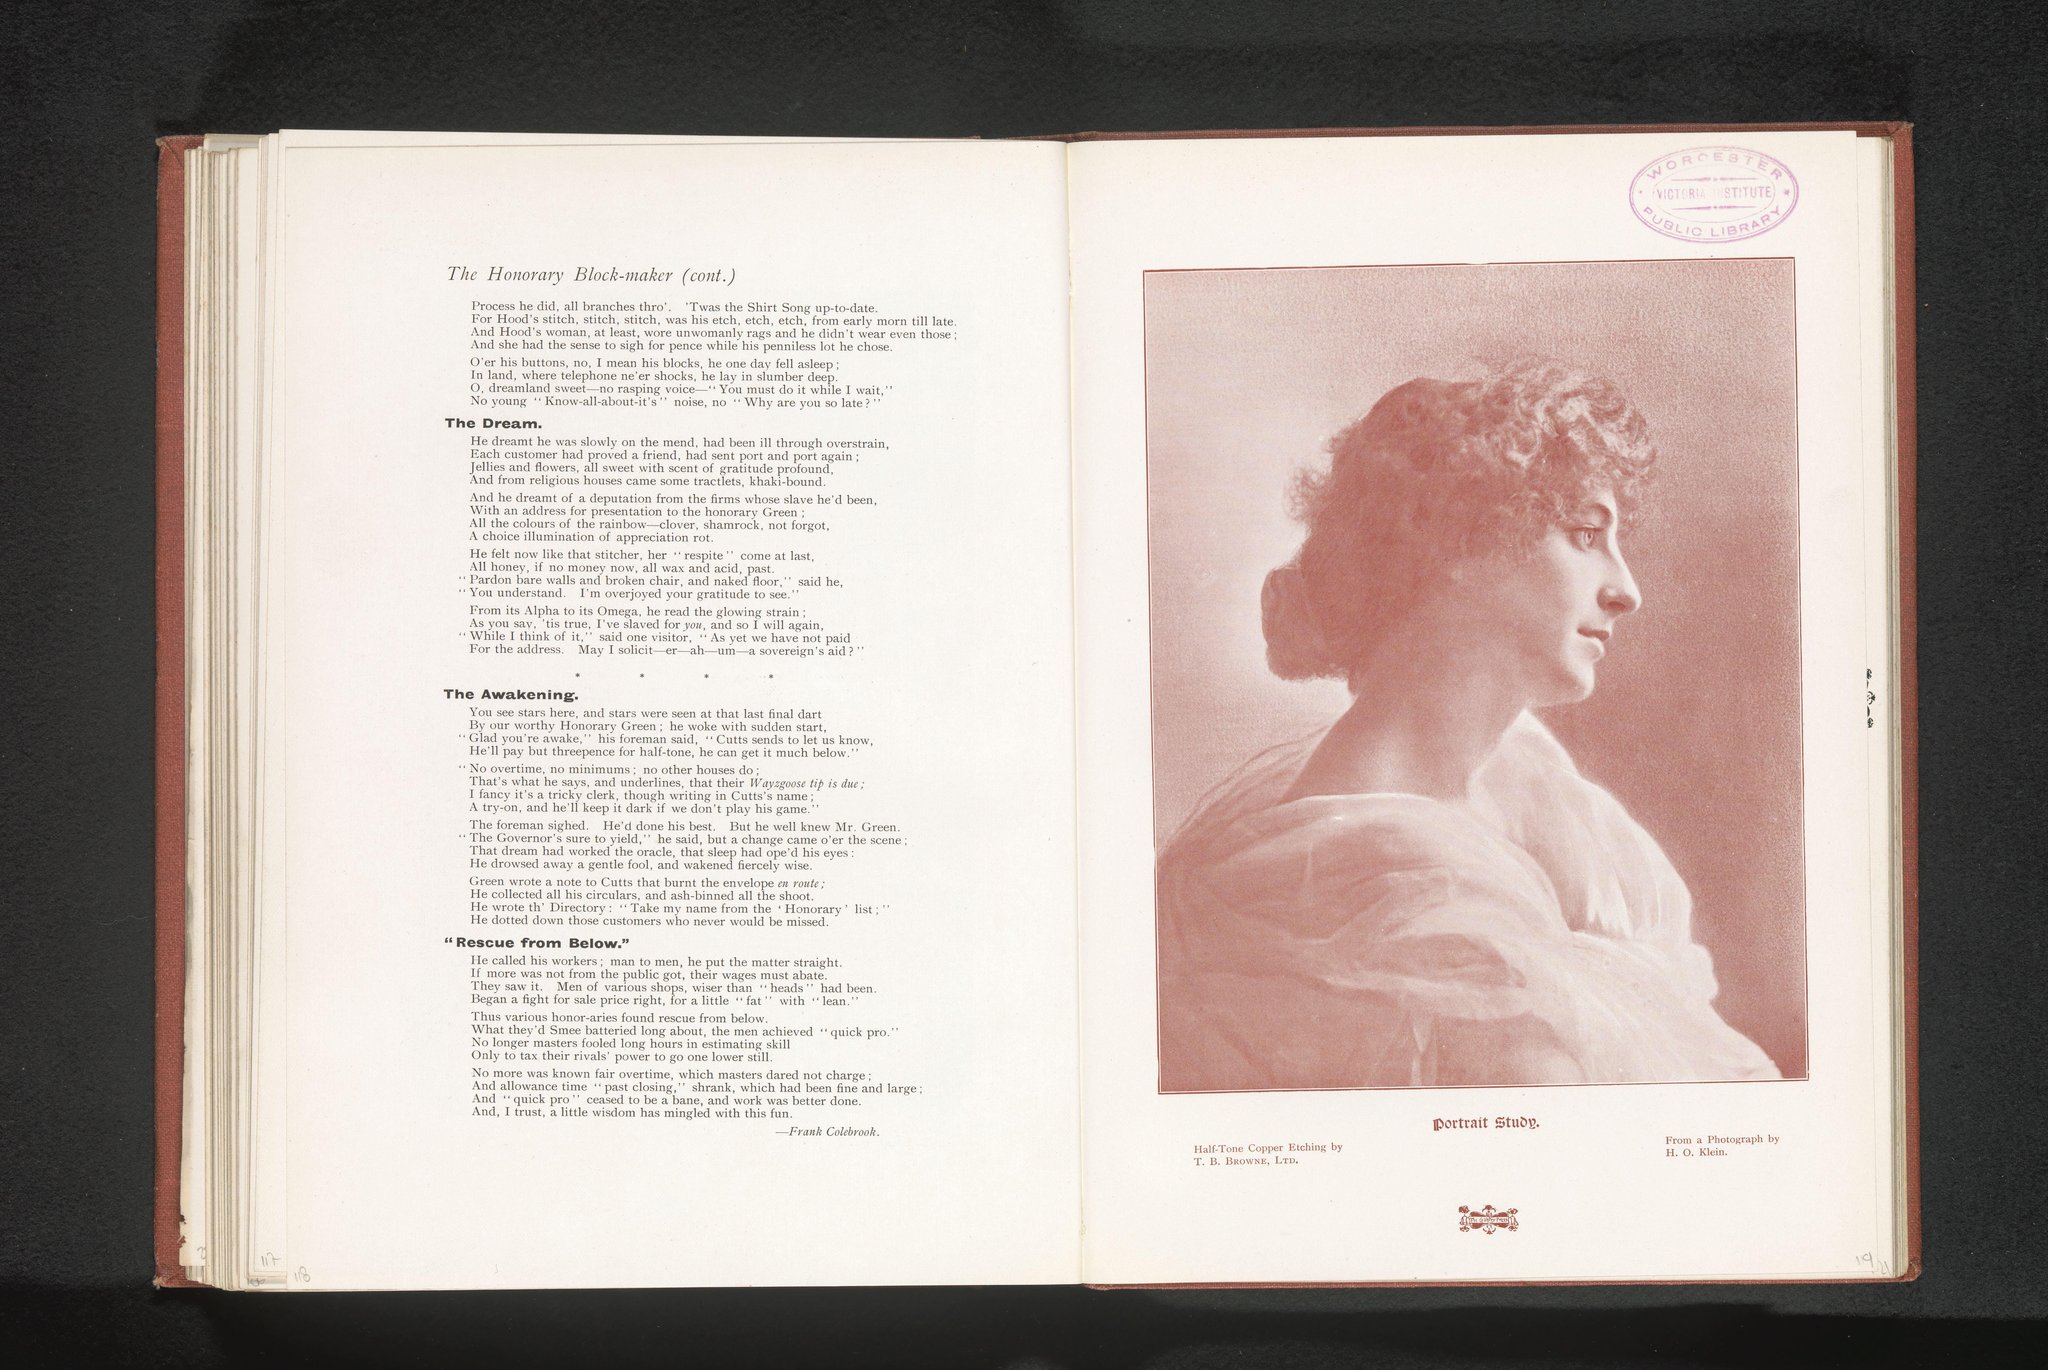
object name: photomechanical print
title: Portretstudie van een onbekende jonge vrouw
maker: h.o. klein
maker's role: fotograaf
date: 1895-1900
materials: paper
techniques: autotype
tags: adolescent, young woman, maiden, historical persons - bb - woman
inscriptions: collector's mark: ‘Worcester Public Library/ Victoria Institute’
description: Prent op zevende ongenummerde pagina na pagina 96.